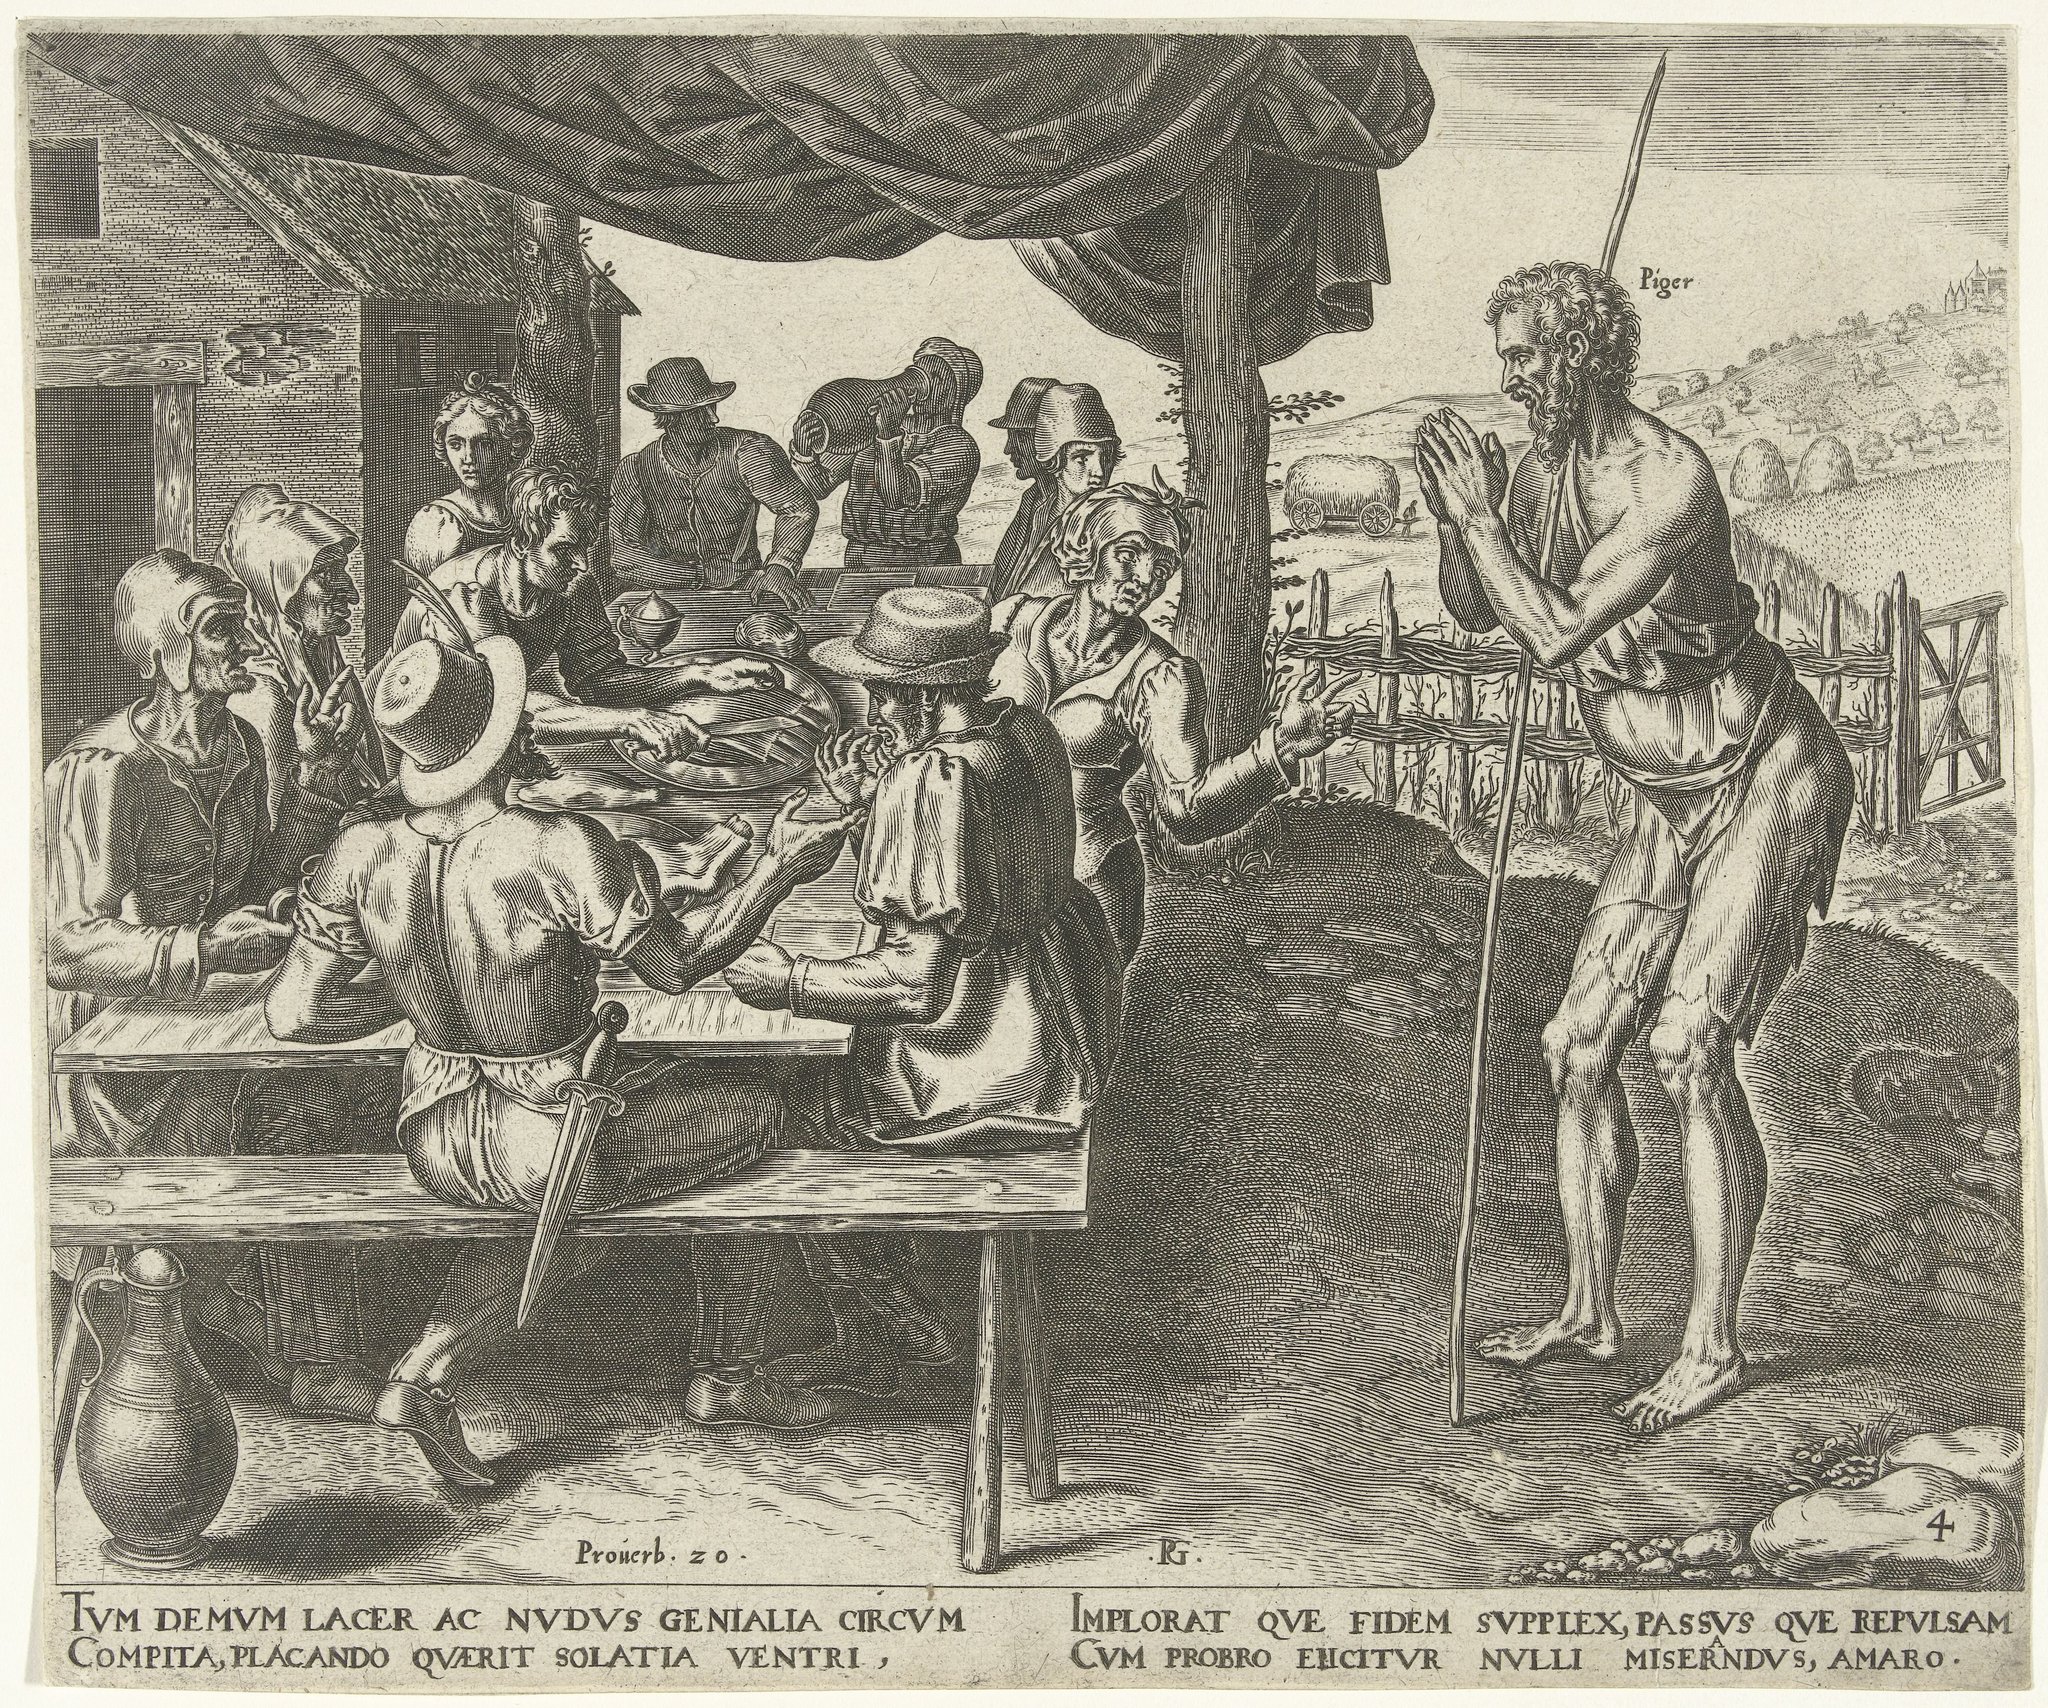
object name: print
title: De luiaard mag niet mee eten na de oogst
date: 1565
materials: paper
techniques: engraving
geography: haarlem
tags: the book of proverbs, harvest festivities (+ eating and drinking ~ festive activities)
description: Mannen en vrouwen zitten naast hun huis in de buitenlucht te eten na de oogst. De luiaard, die niet heeft geholpen bij het oogsten, wordt van tafel geweerd. Hij maakt met zijn handen een biddend gebaar, maar wordt weggestuurd.